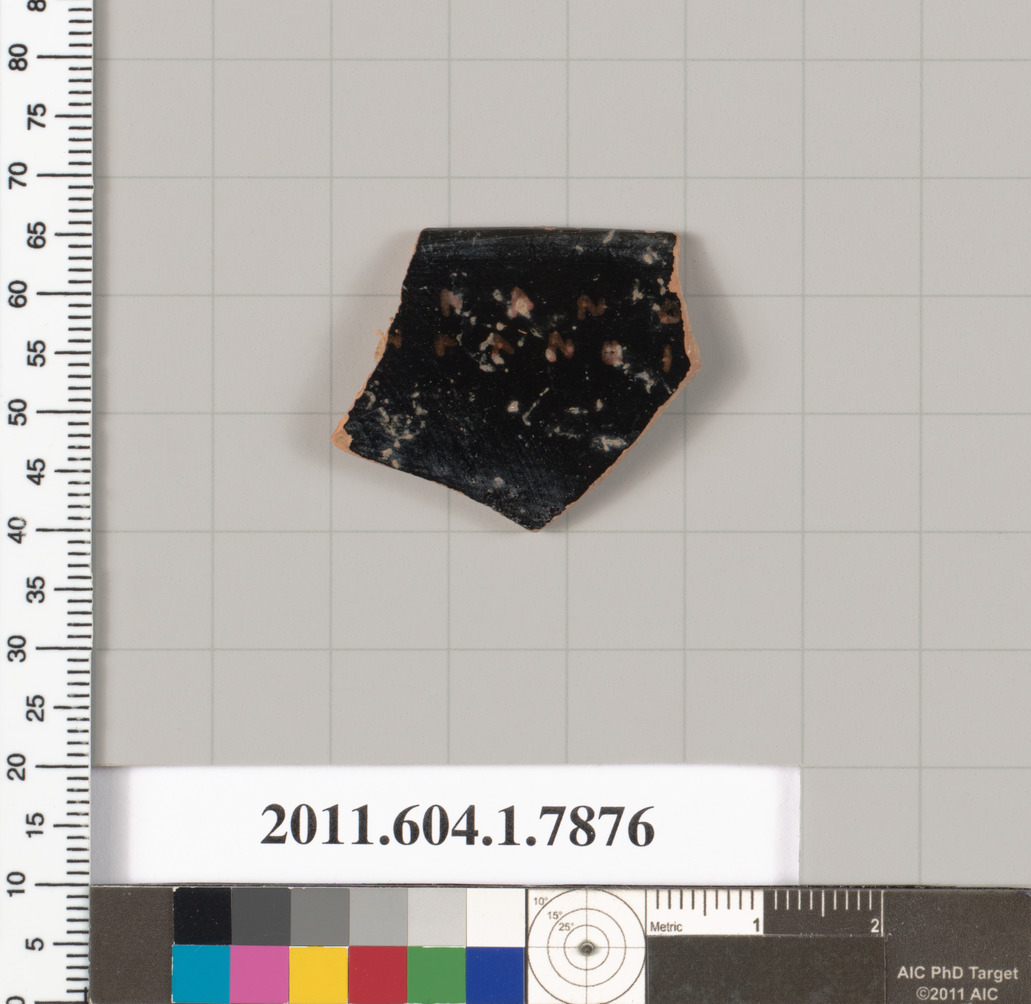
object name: kylix fragment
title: Terracotta rim fragment of a kylix (drinking cup)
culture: greek, attic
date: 460-450 BCE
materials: terracotta